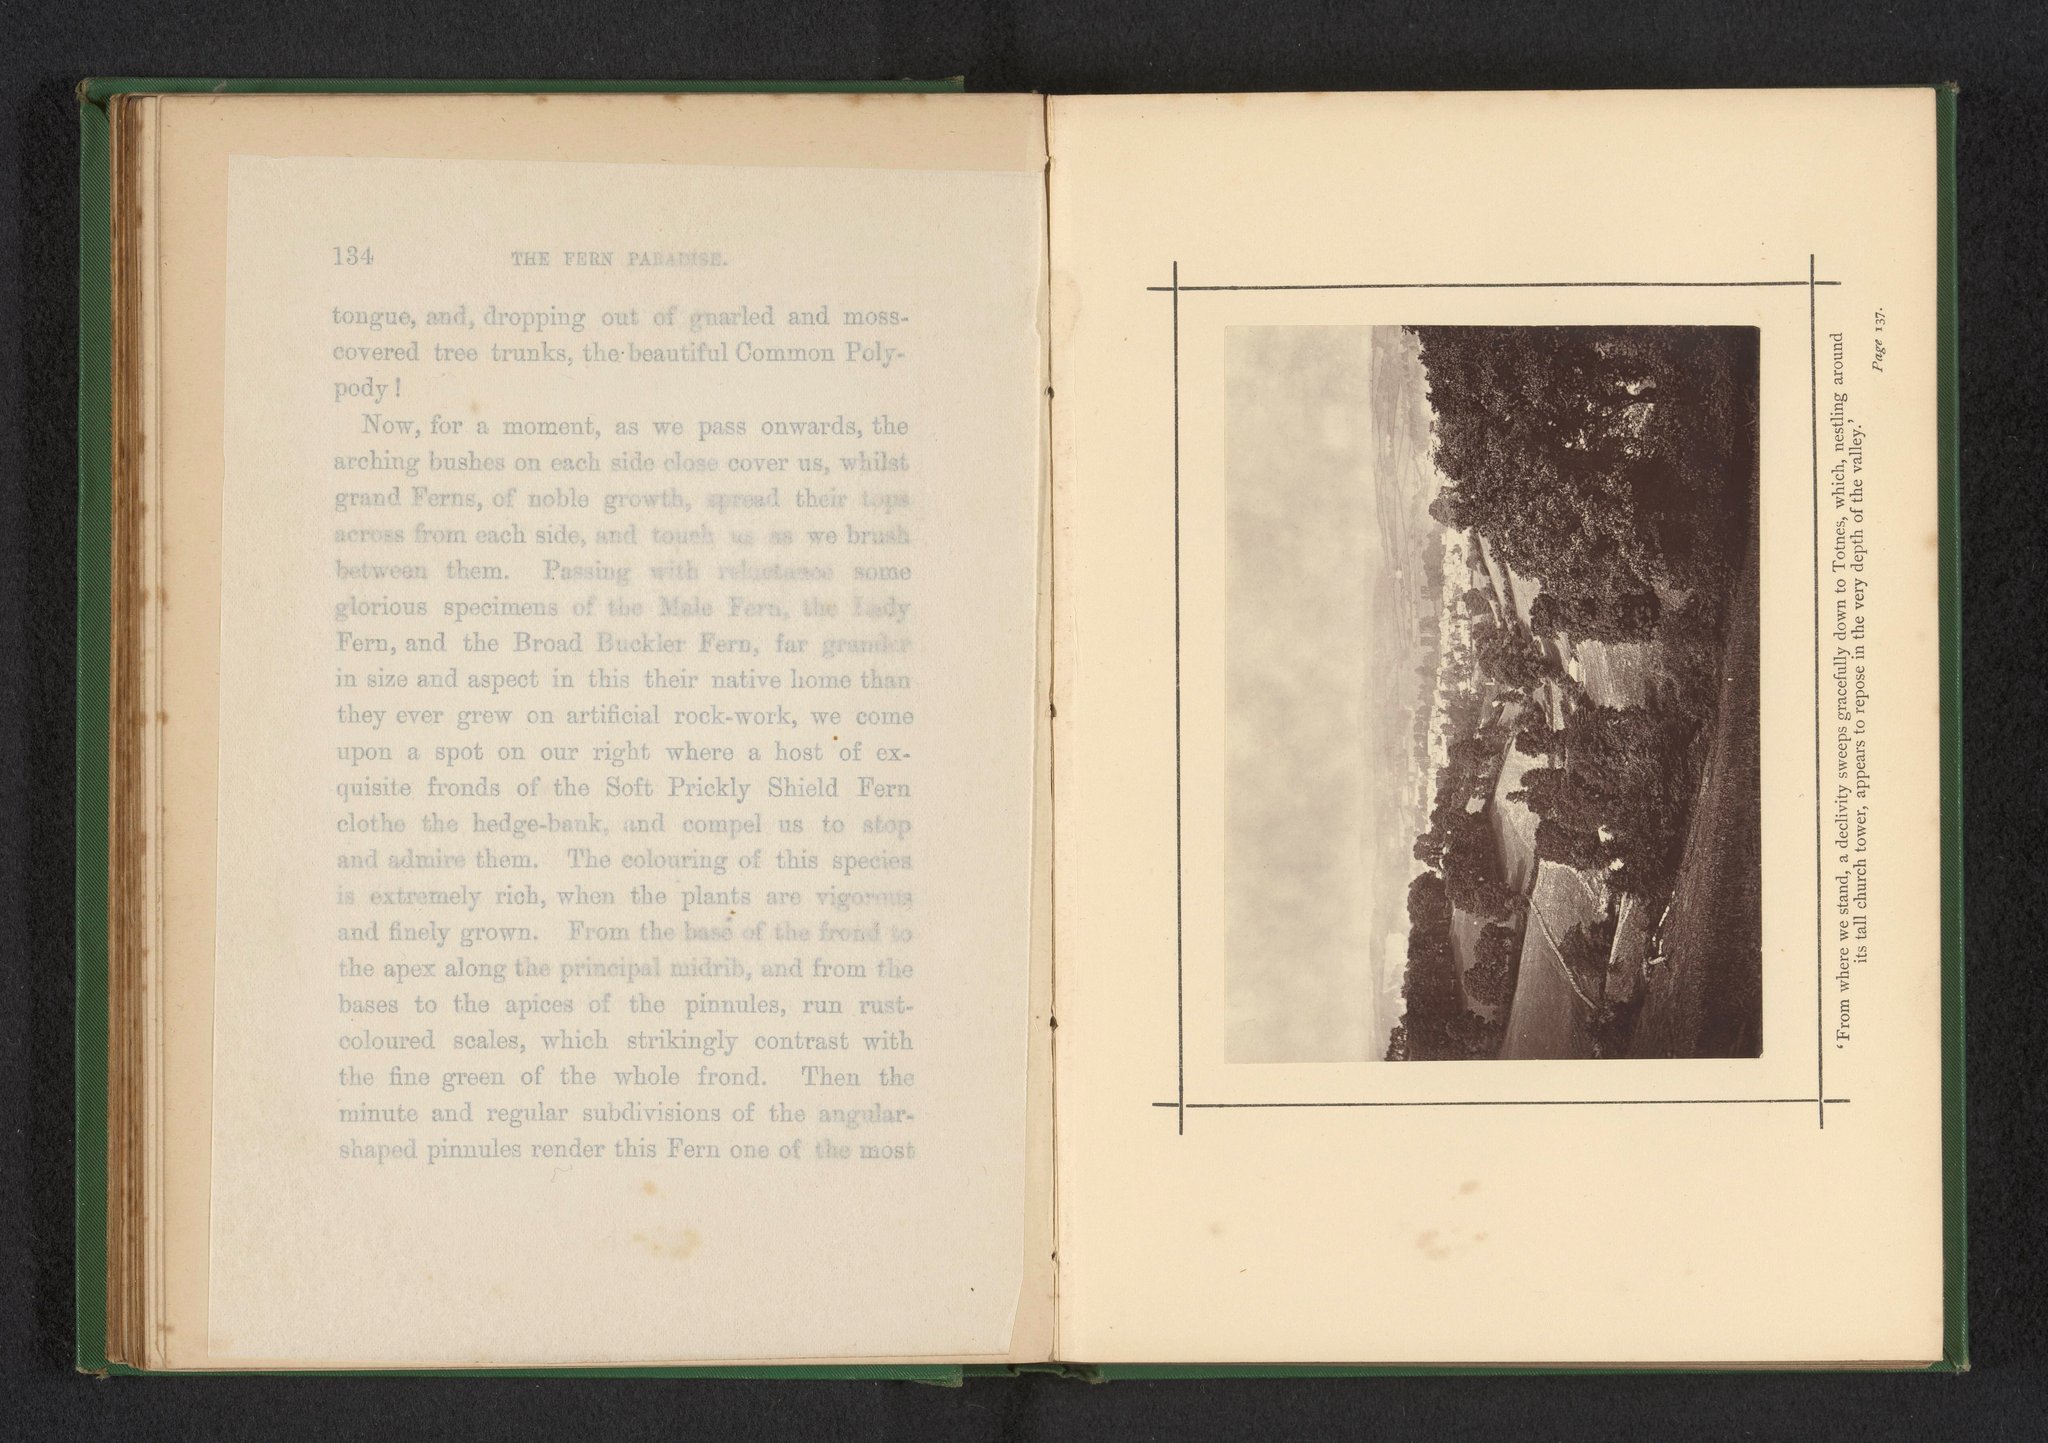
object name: photomechanical print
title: Gezicht op een vallei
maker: Anonymous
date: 1868-1878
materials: paper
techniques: woodburytype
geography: totnes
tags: dale, valley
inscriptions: inscription: ‘'From where we stand, a declivity sweeps gracefully down to Totnes, which, nestling around its tall church tower, appears to repose in the very depth of the valley.' Page 137.’